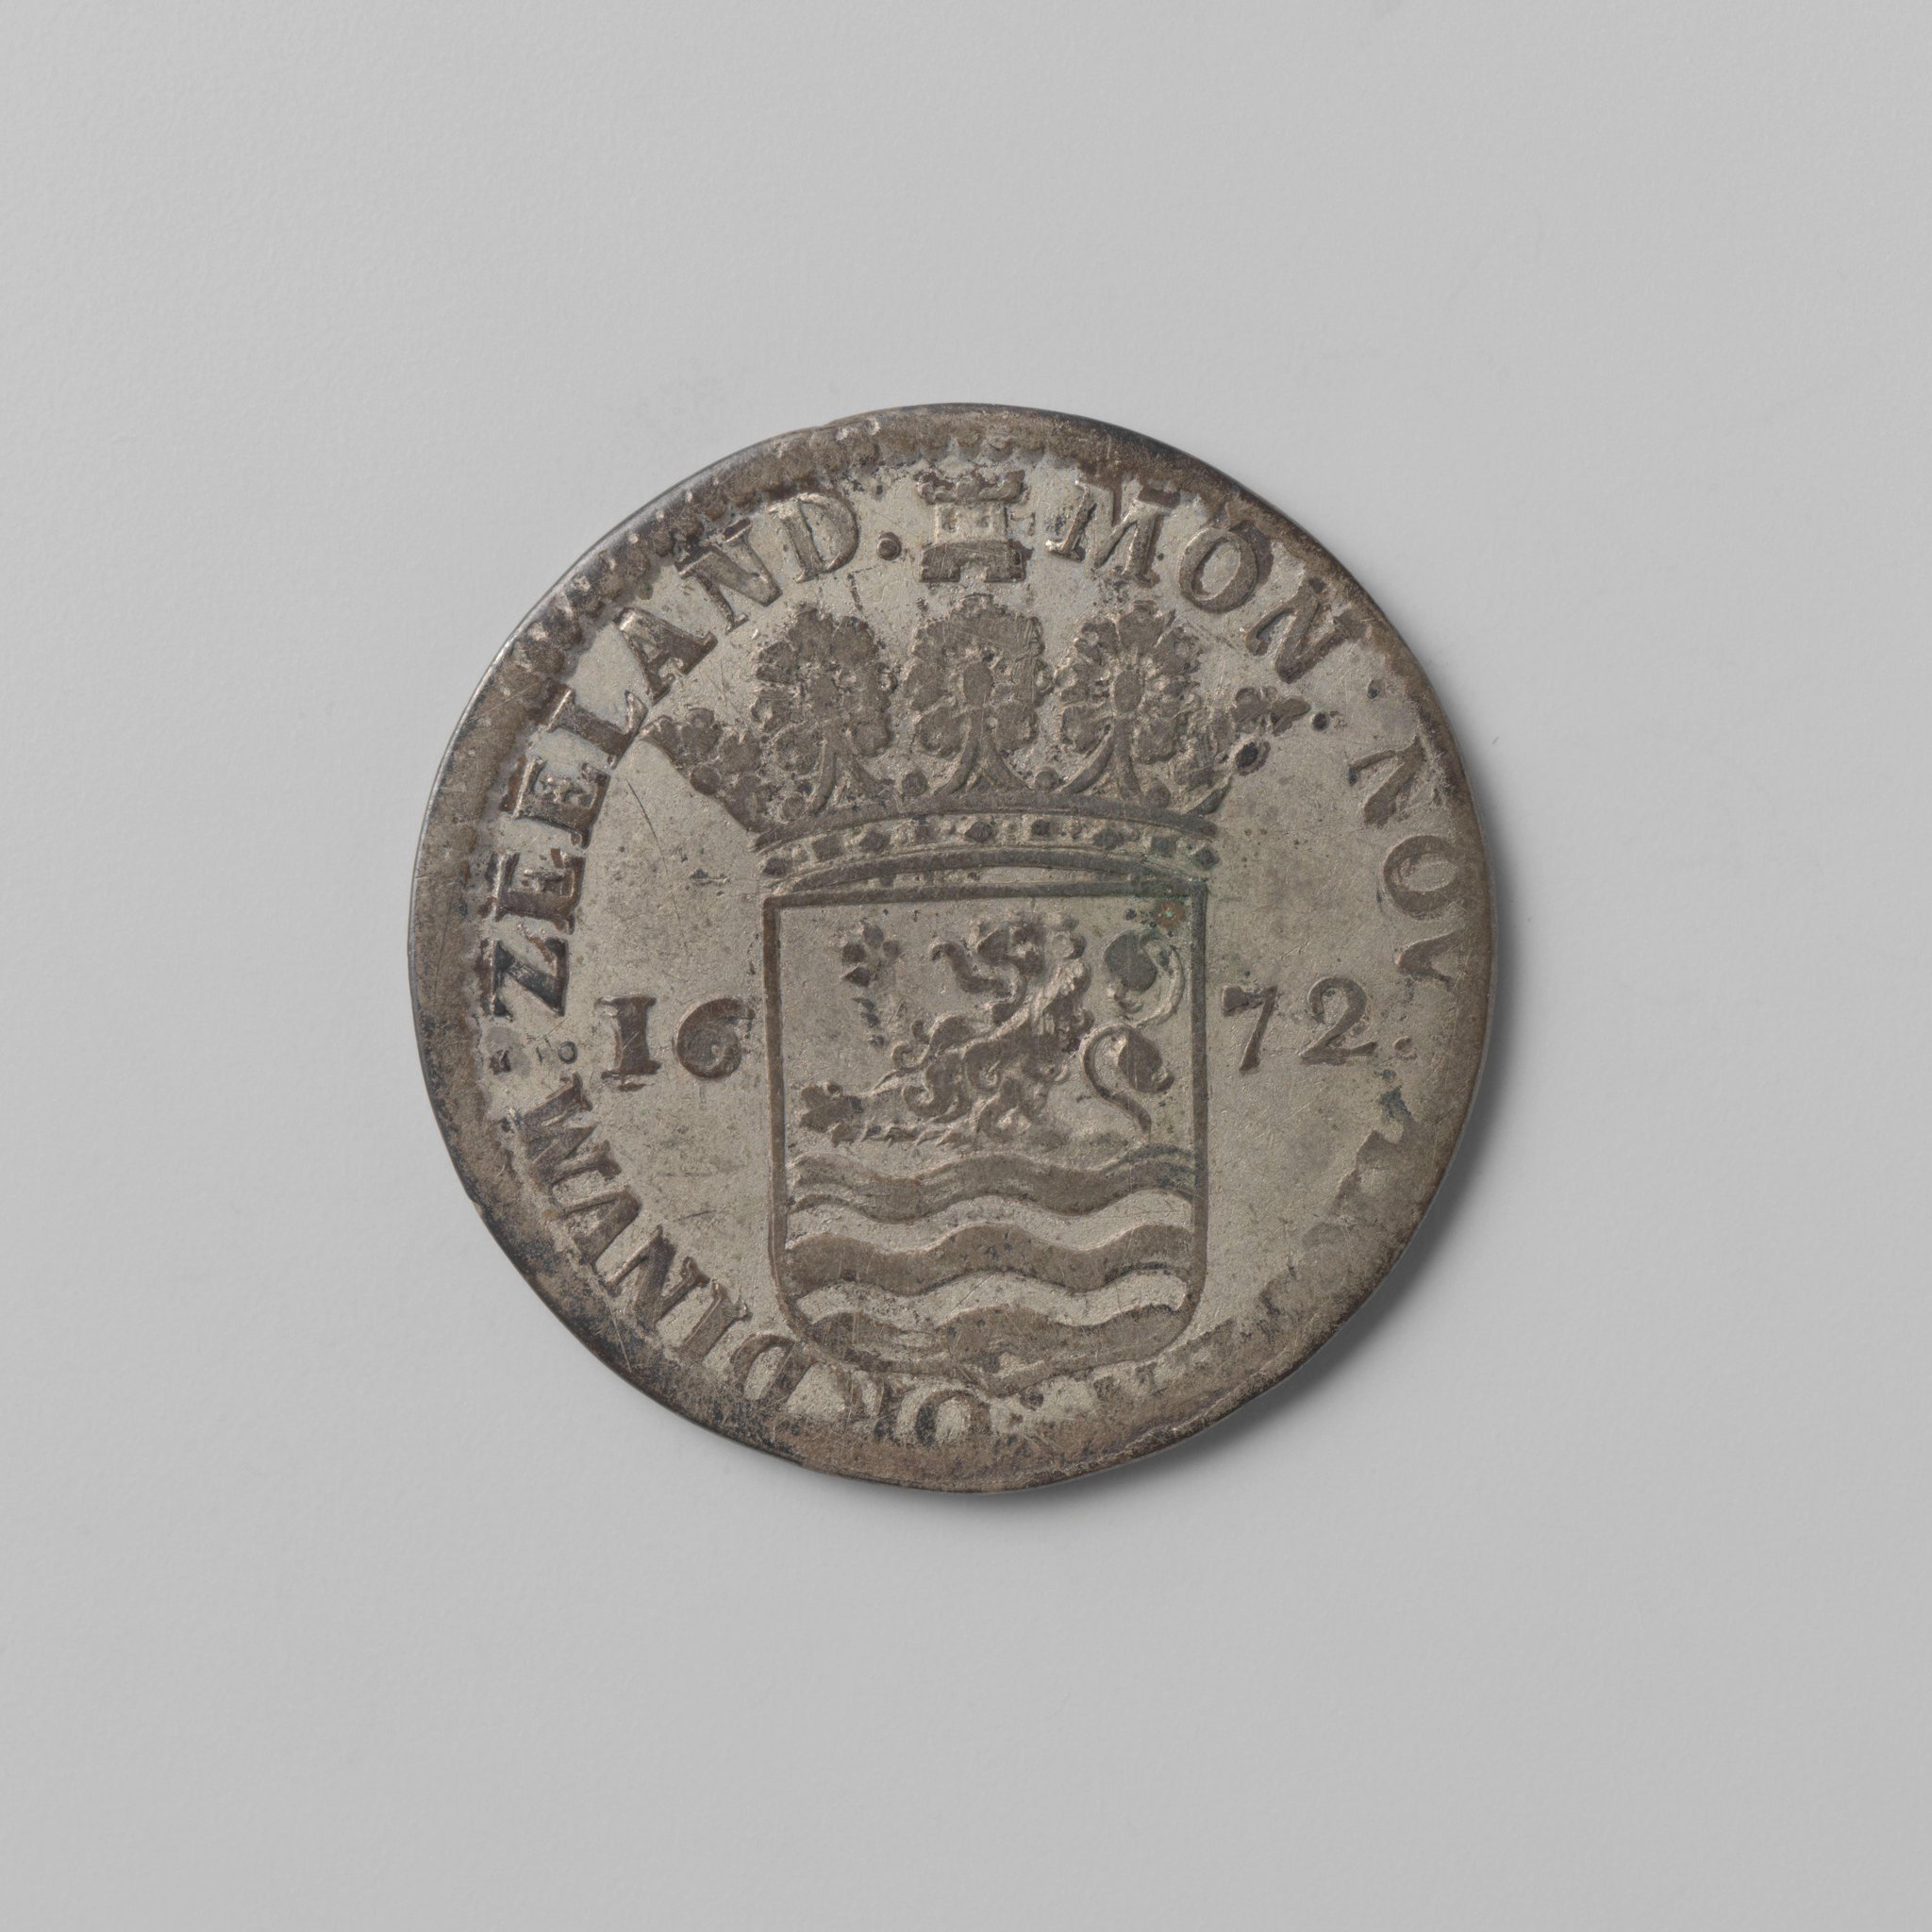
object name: coin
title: Zeeland, hoedjesschelling, 1672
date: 1672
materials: silver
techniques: striking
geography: middelburg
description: Zilveren munt. Voorzijde: tussen jaartal gekroond wapenschild van Zeeland. Boven kroon in omschrift muntteken burcht. Keerzijde: liggende leeuw naar links met vrijheidshoed op speer.